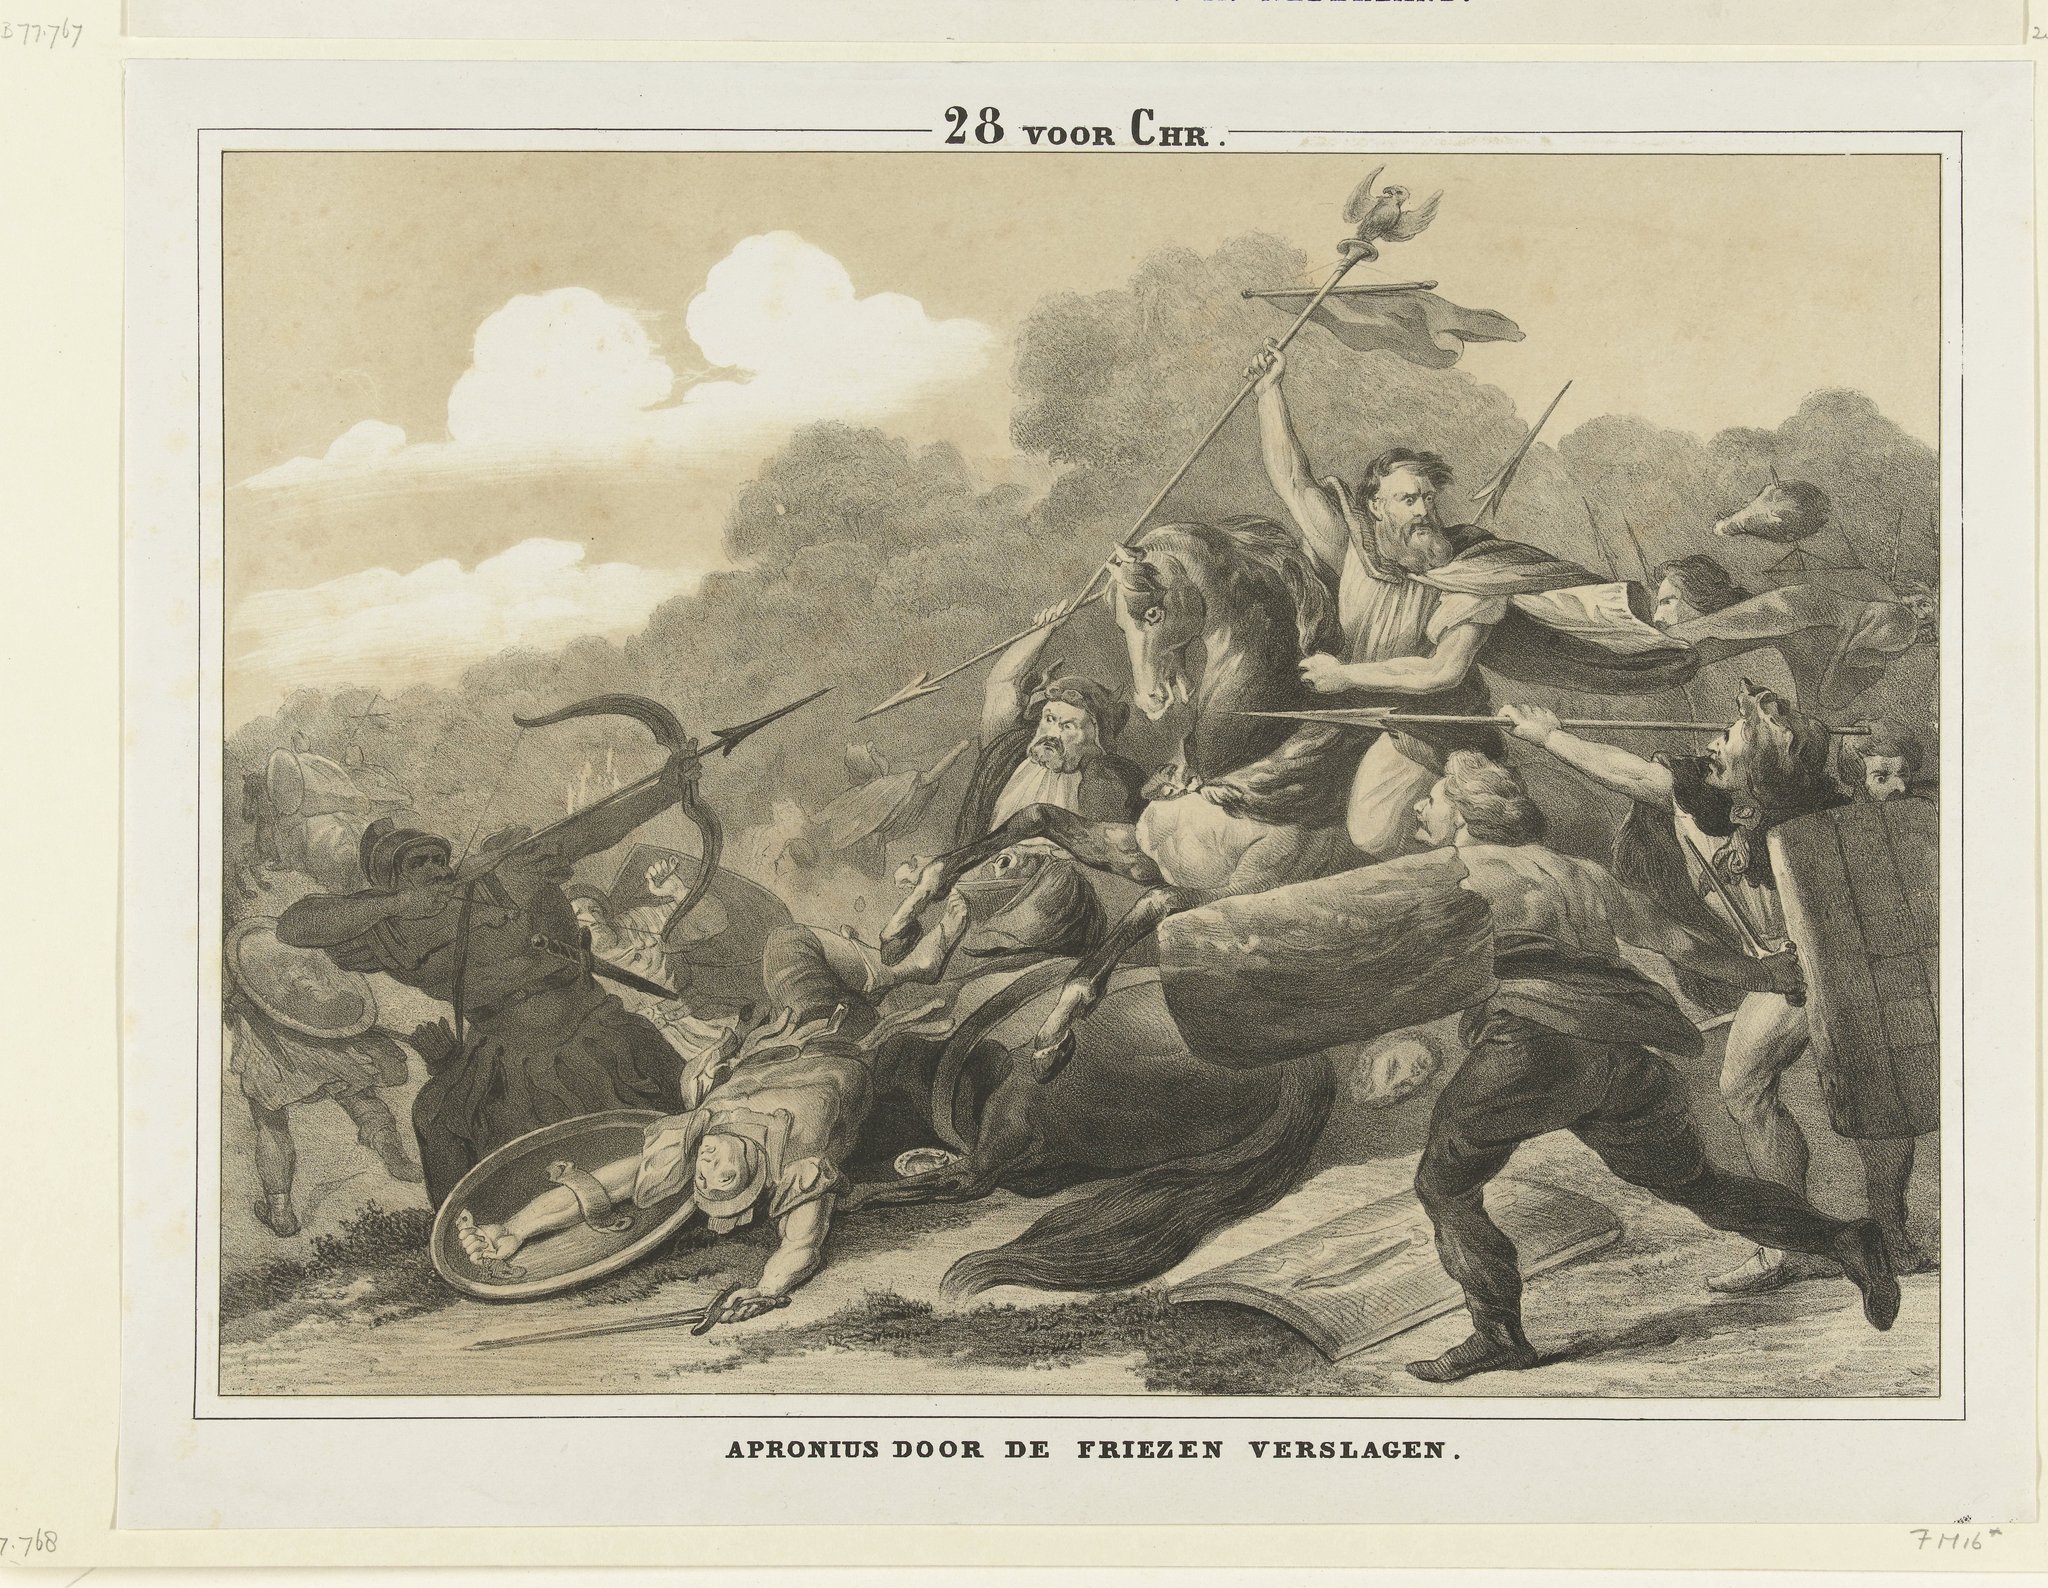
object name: history print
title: 28 voor Chr. / Apronius door de Friezen verslagen,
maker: tieleman cato bruining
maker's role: print maker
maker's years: 1801-1877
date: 1850-1855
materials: paper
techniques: lithograph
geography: netherlands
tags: extinct, 'historical' peoples (frisians)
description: Illustratie voor: J.H. Eichman & H. Altmann, Vaderlandsche historieplaten voor scholen en huisgezinnen, Leiden, 1855. Dit nummer is een door het RPK toegevoegd nummer en staat niet in Frederik Muller, het werk waar de prent voor is gemaakt of uit afkomstig is, staat wel vermeld in Frederik Muller.